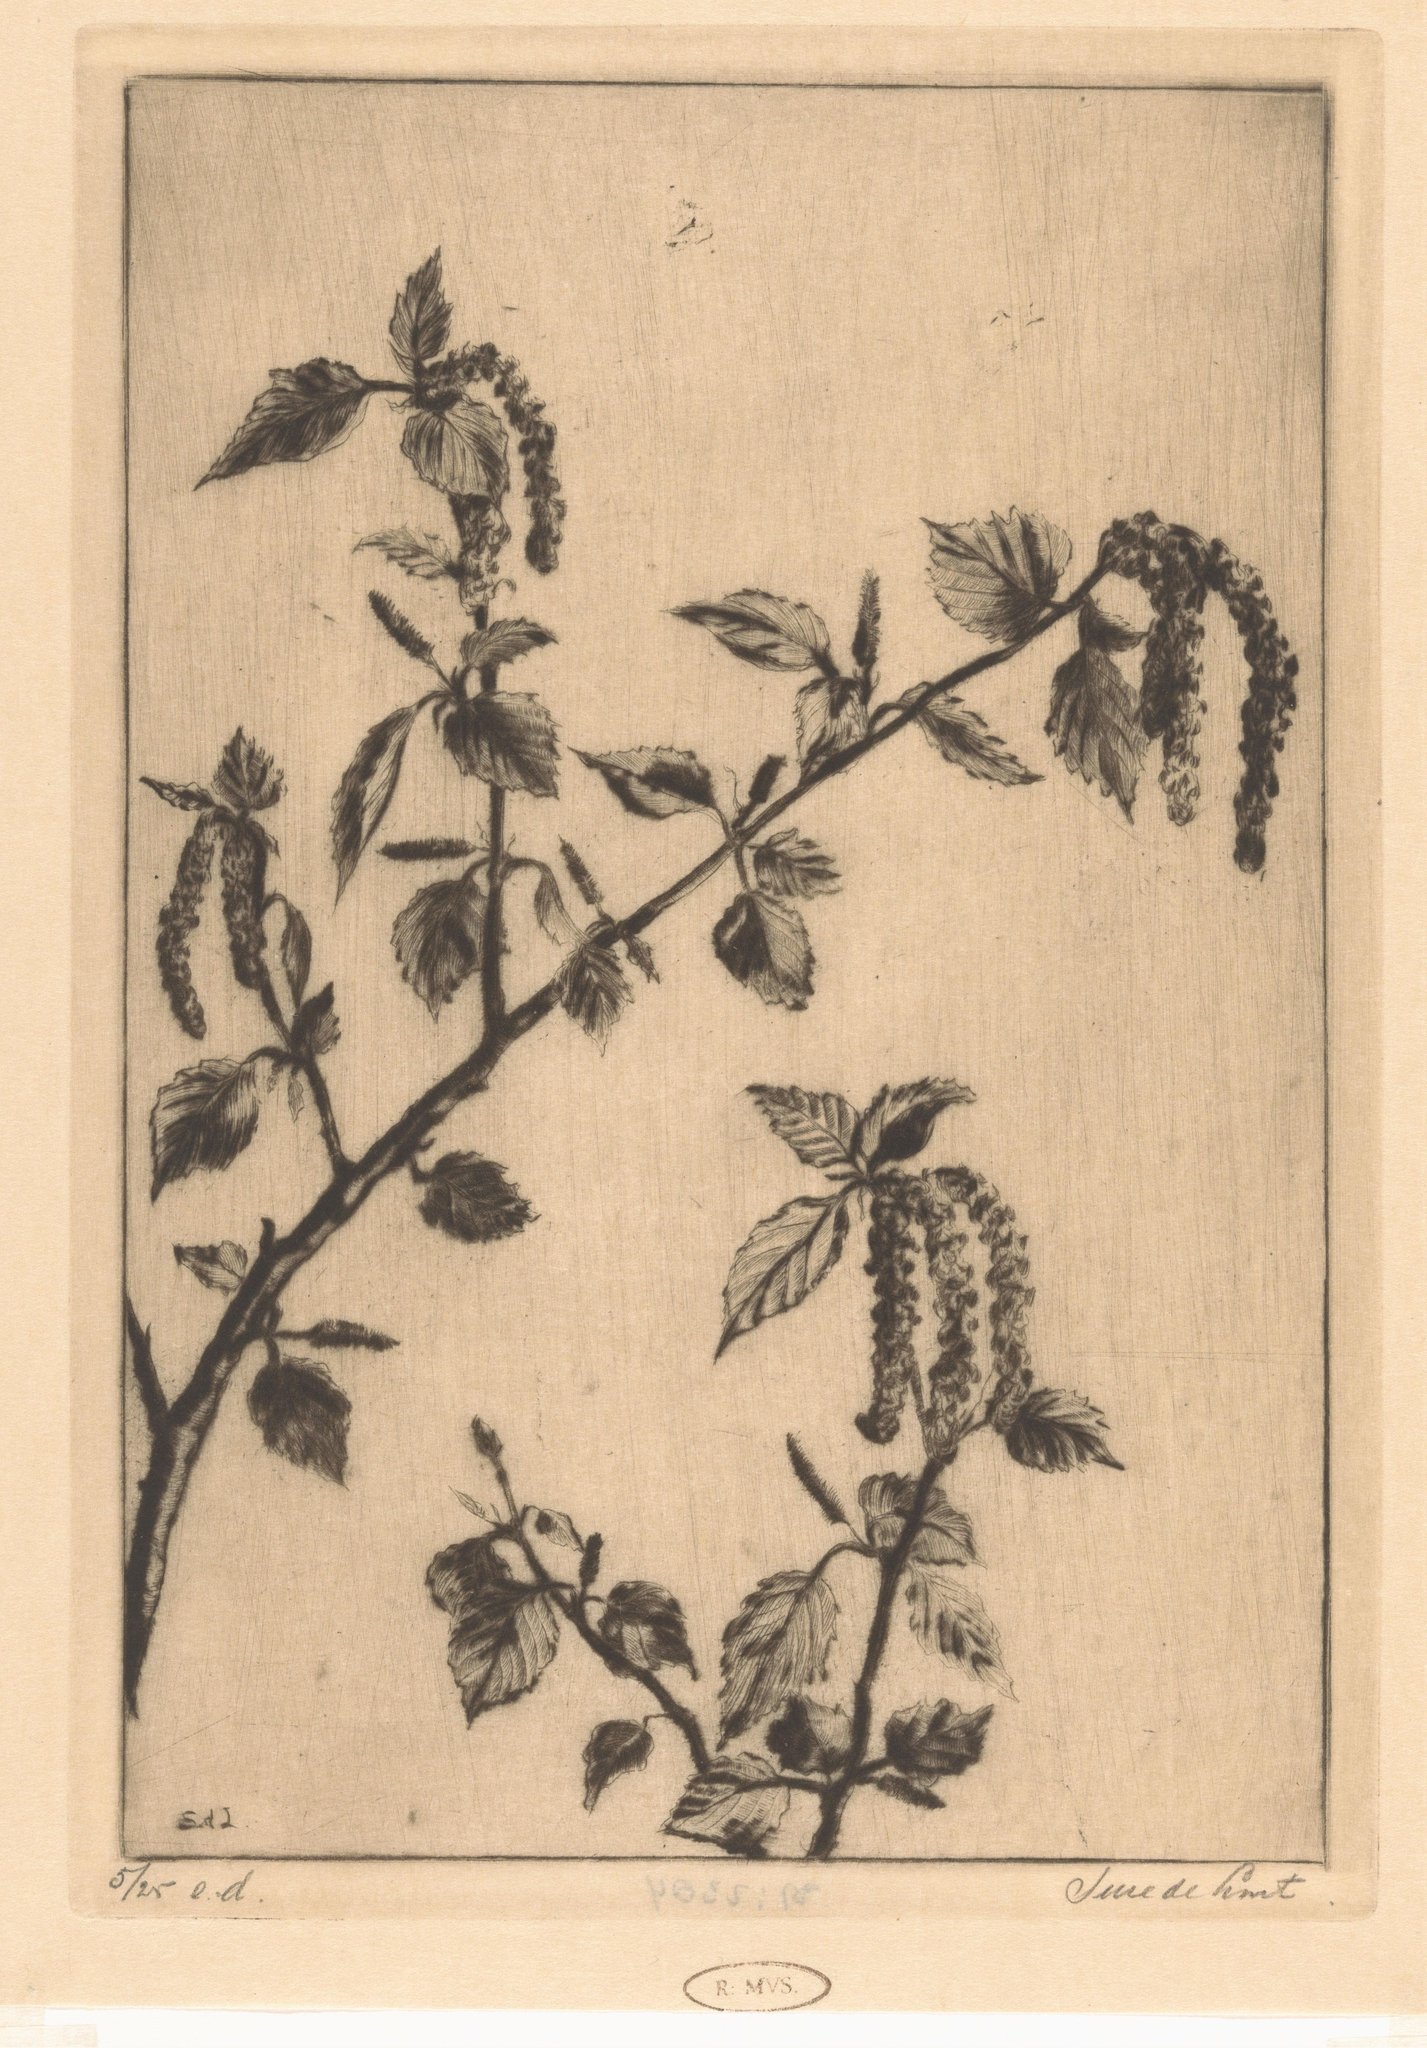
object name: print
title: Berkenkatjes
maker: suze de lint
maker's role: print maker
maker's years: 1878-1953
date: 1888-1931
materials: paper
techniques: etching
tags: trees: birch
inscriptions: collector's mark: Lugt 2228